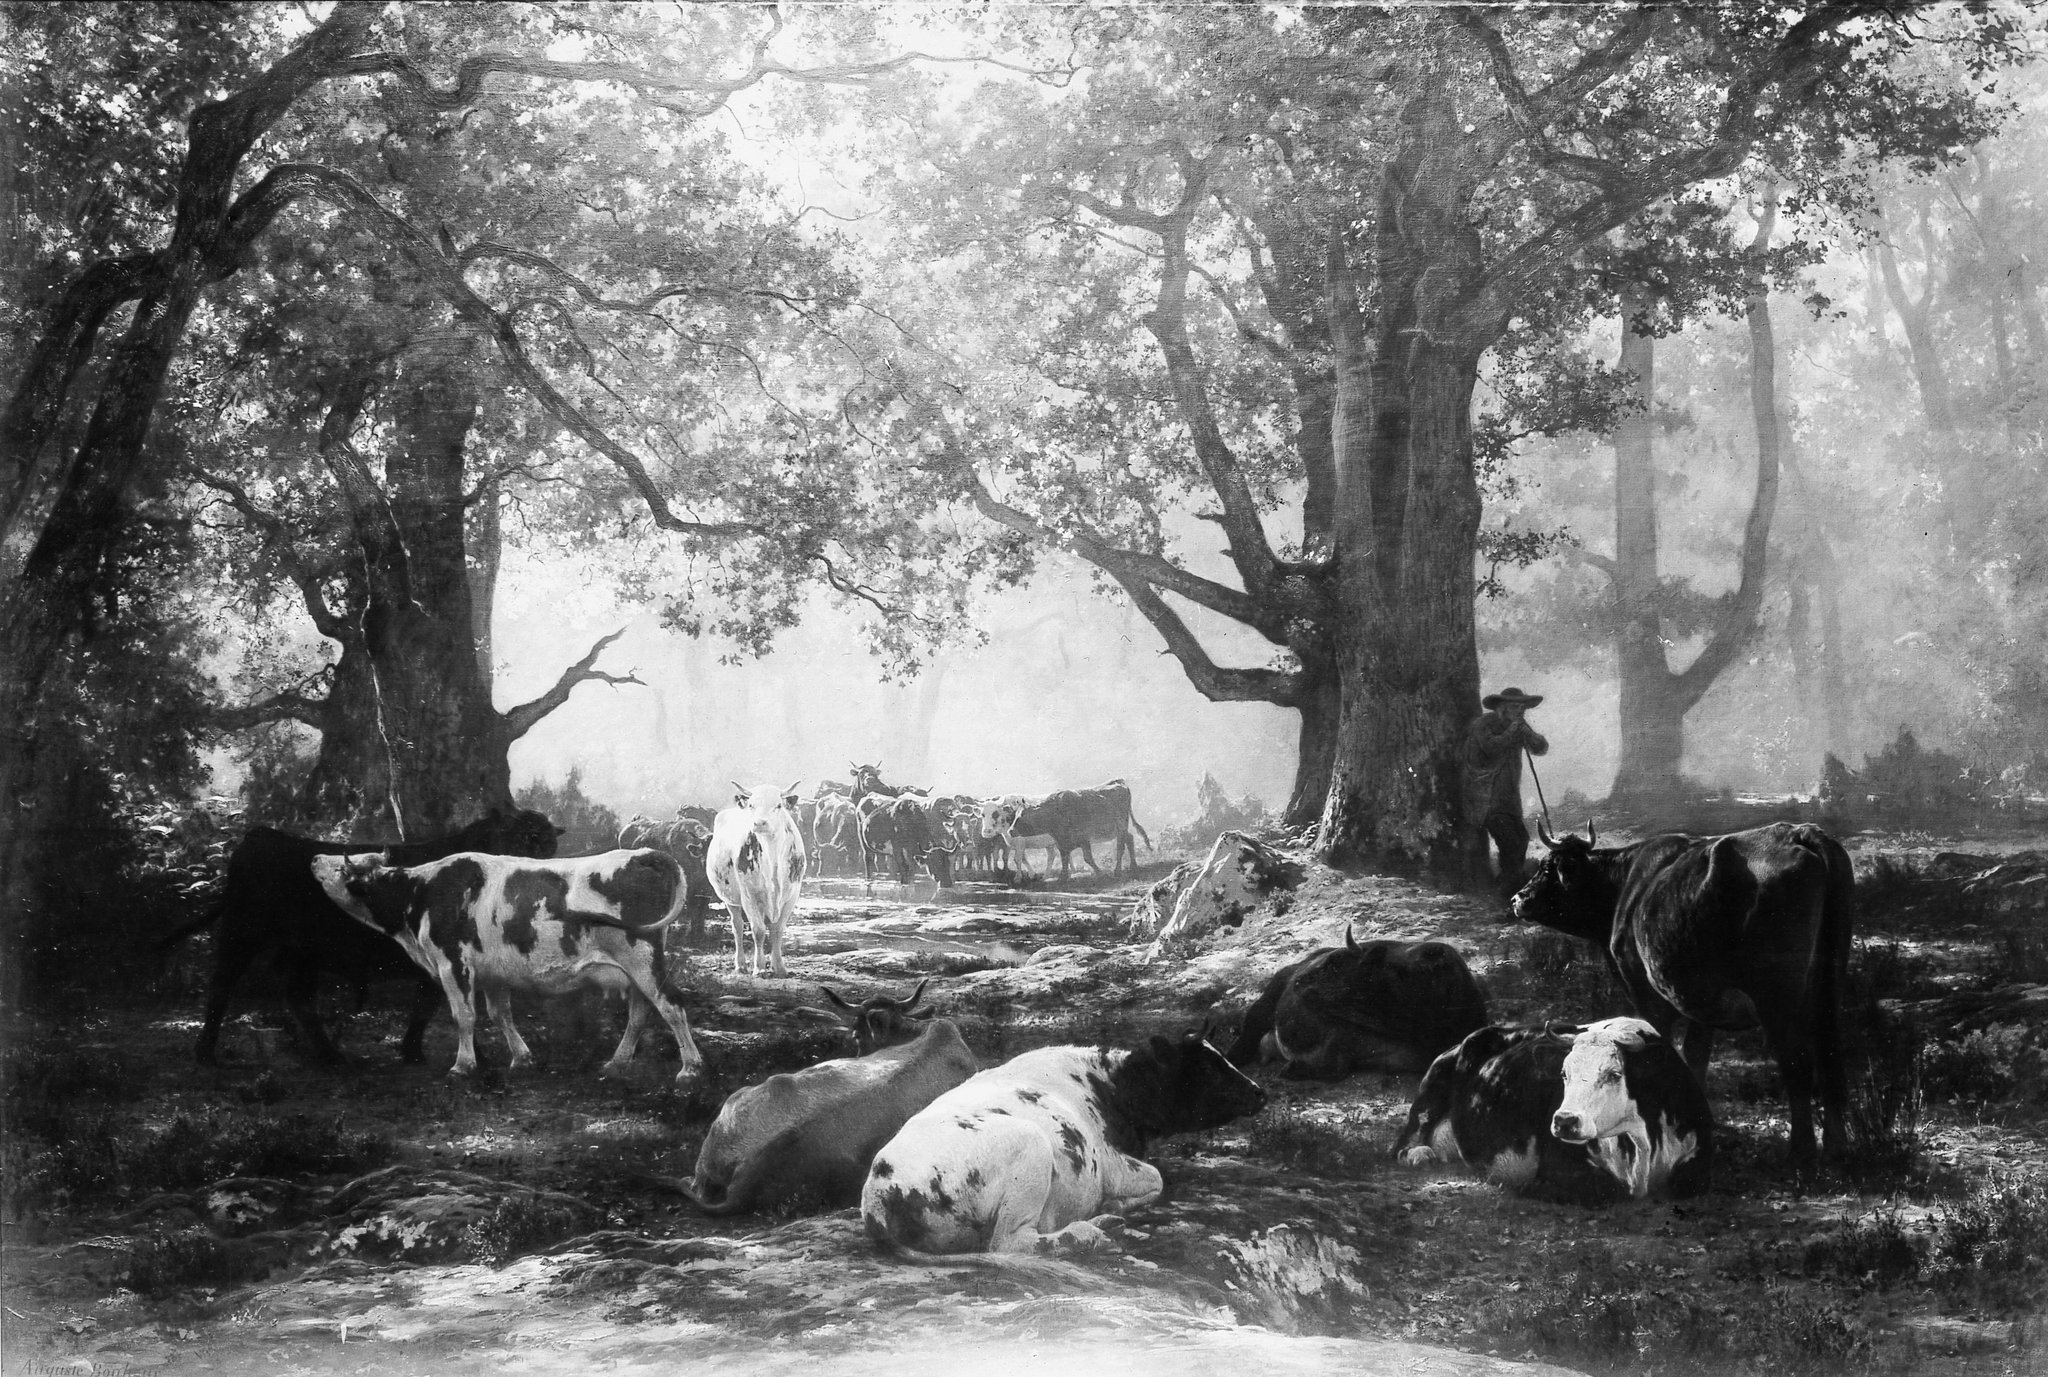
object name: painting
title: Environs of Fontainebleau: Woodland and Cattle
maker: auguste-françois bonheur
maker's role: artist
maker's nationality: french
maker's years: 1824-1884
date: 1844-1884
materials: canvas, oil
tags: cows,forests